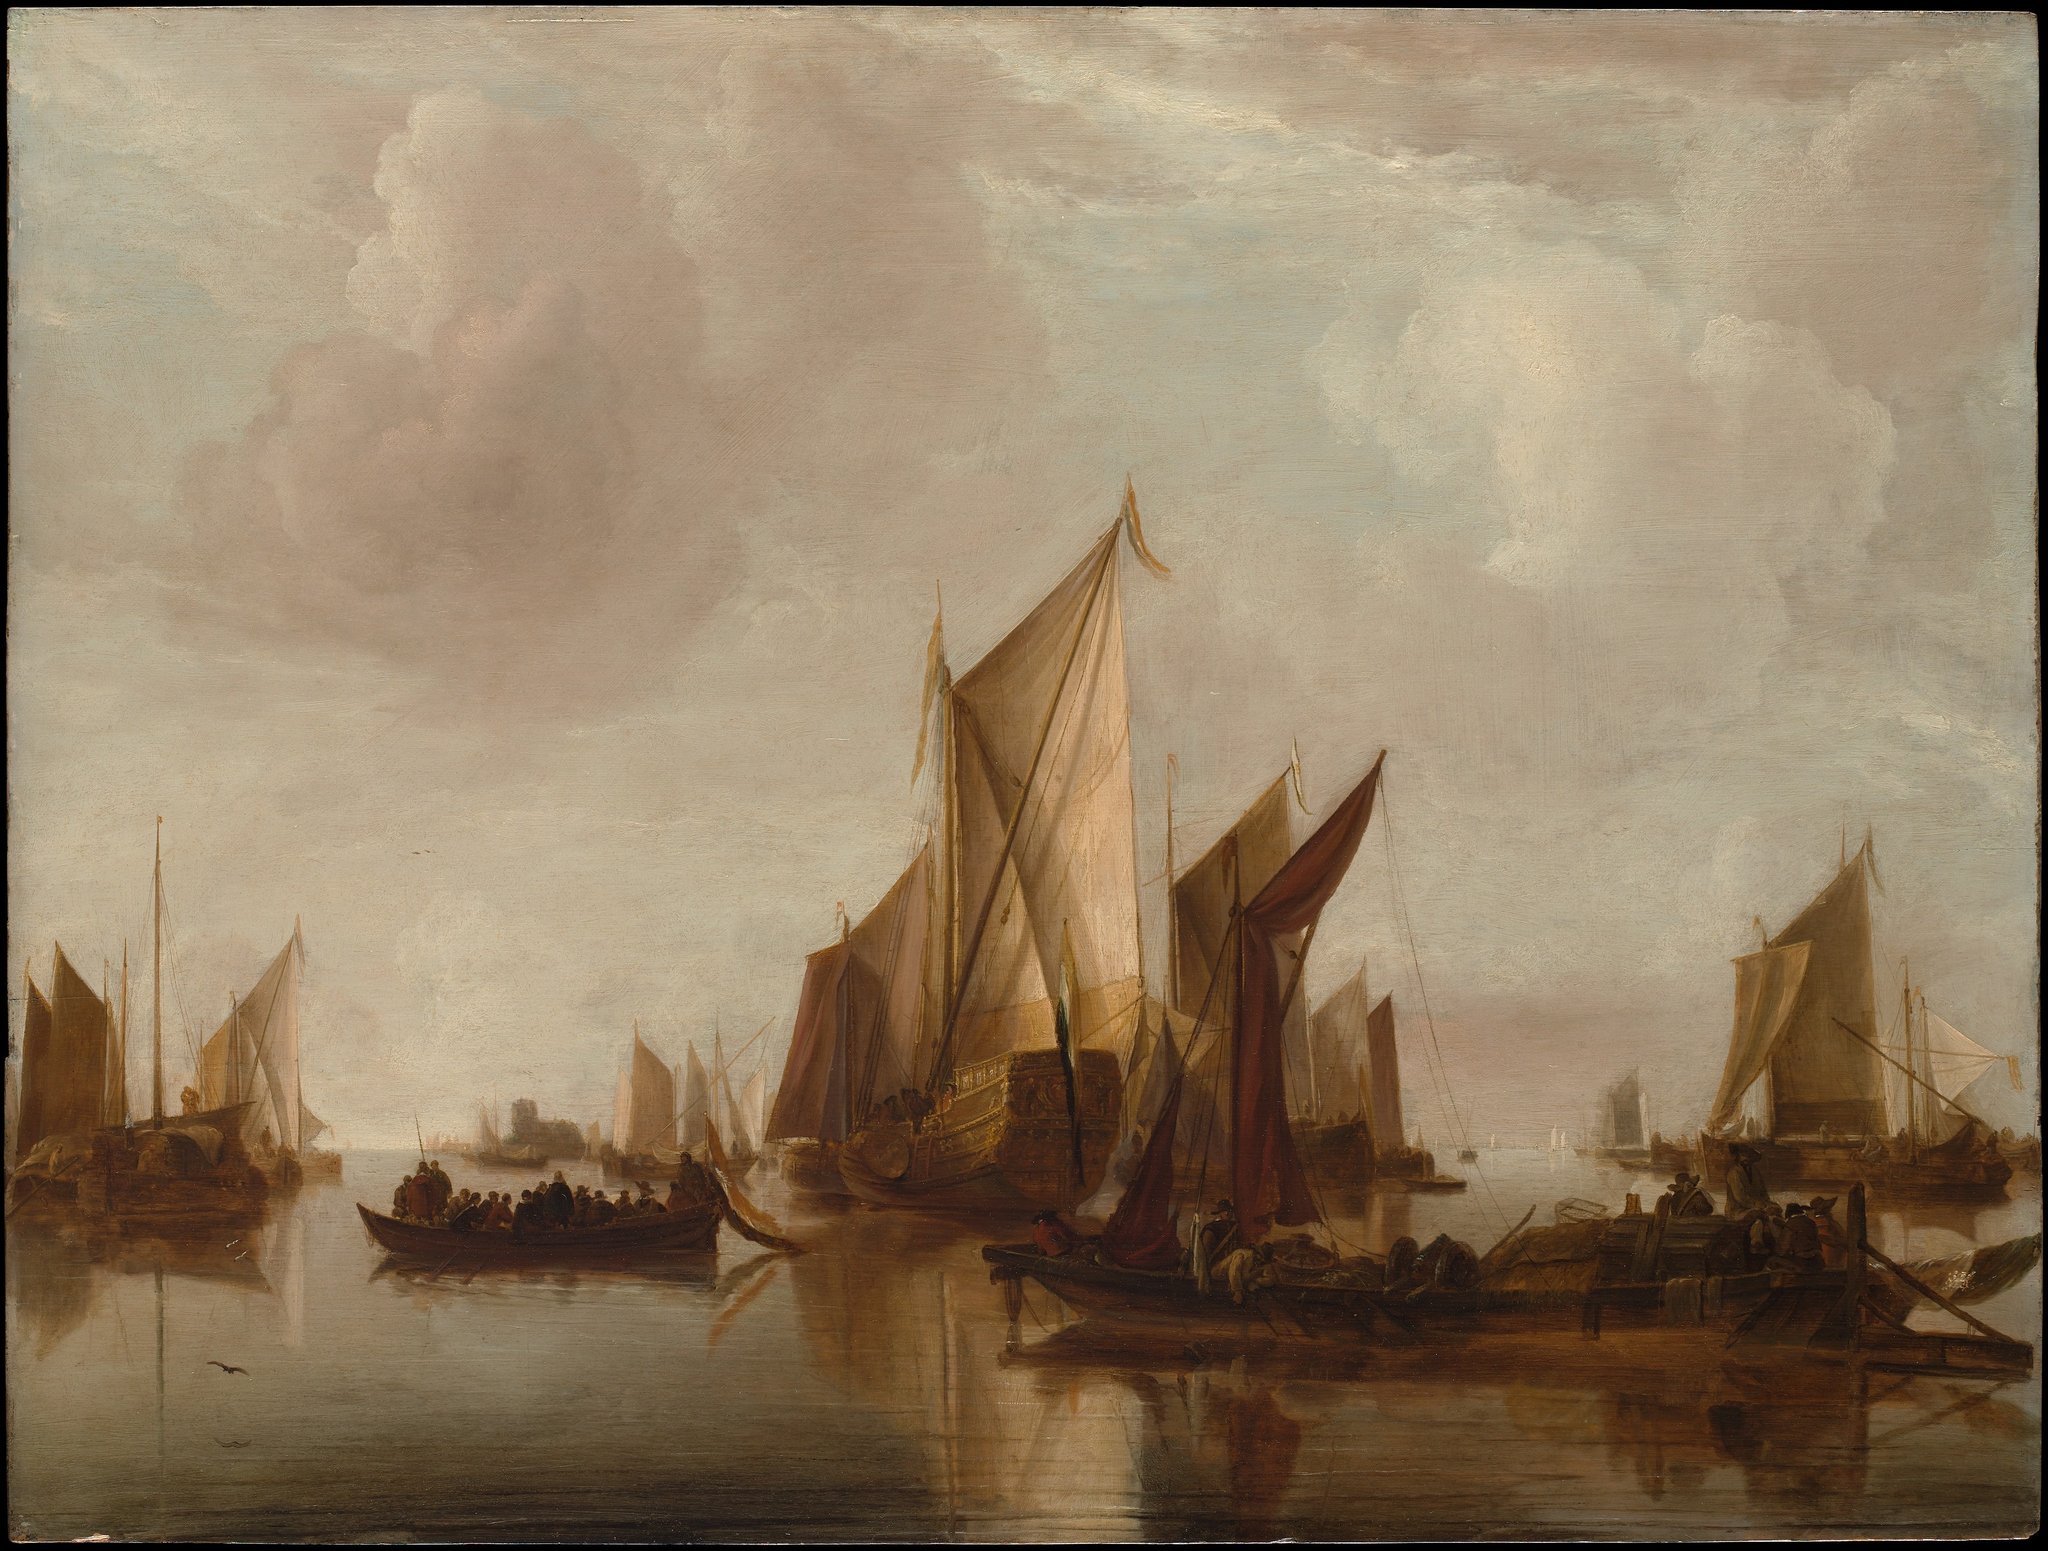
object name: painting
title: A State Yacht and Other Craft in Calm Water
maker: jan van de cappelle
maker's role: artist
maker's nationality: dutch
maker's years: 1626-1679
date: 1660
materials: oil, wood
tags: boats,ships